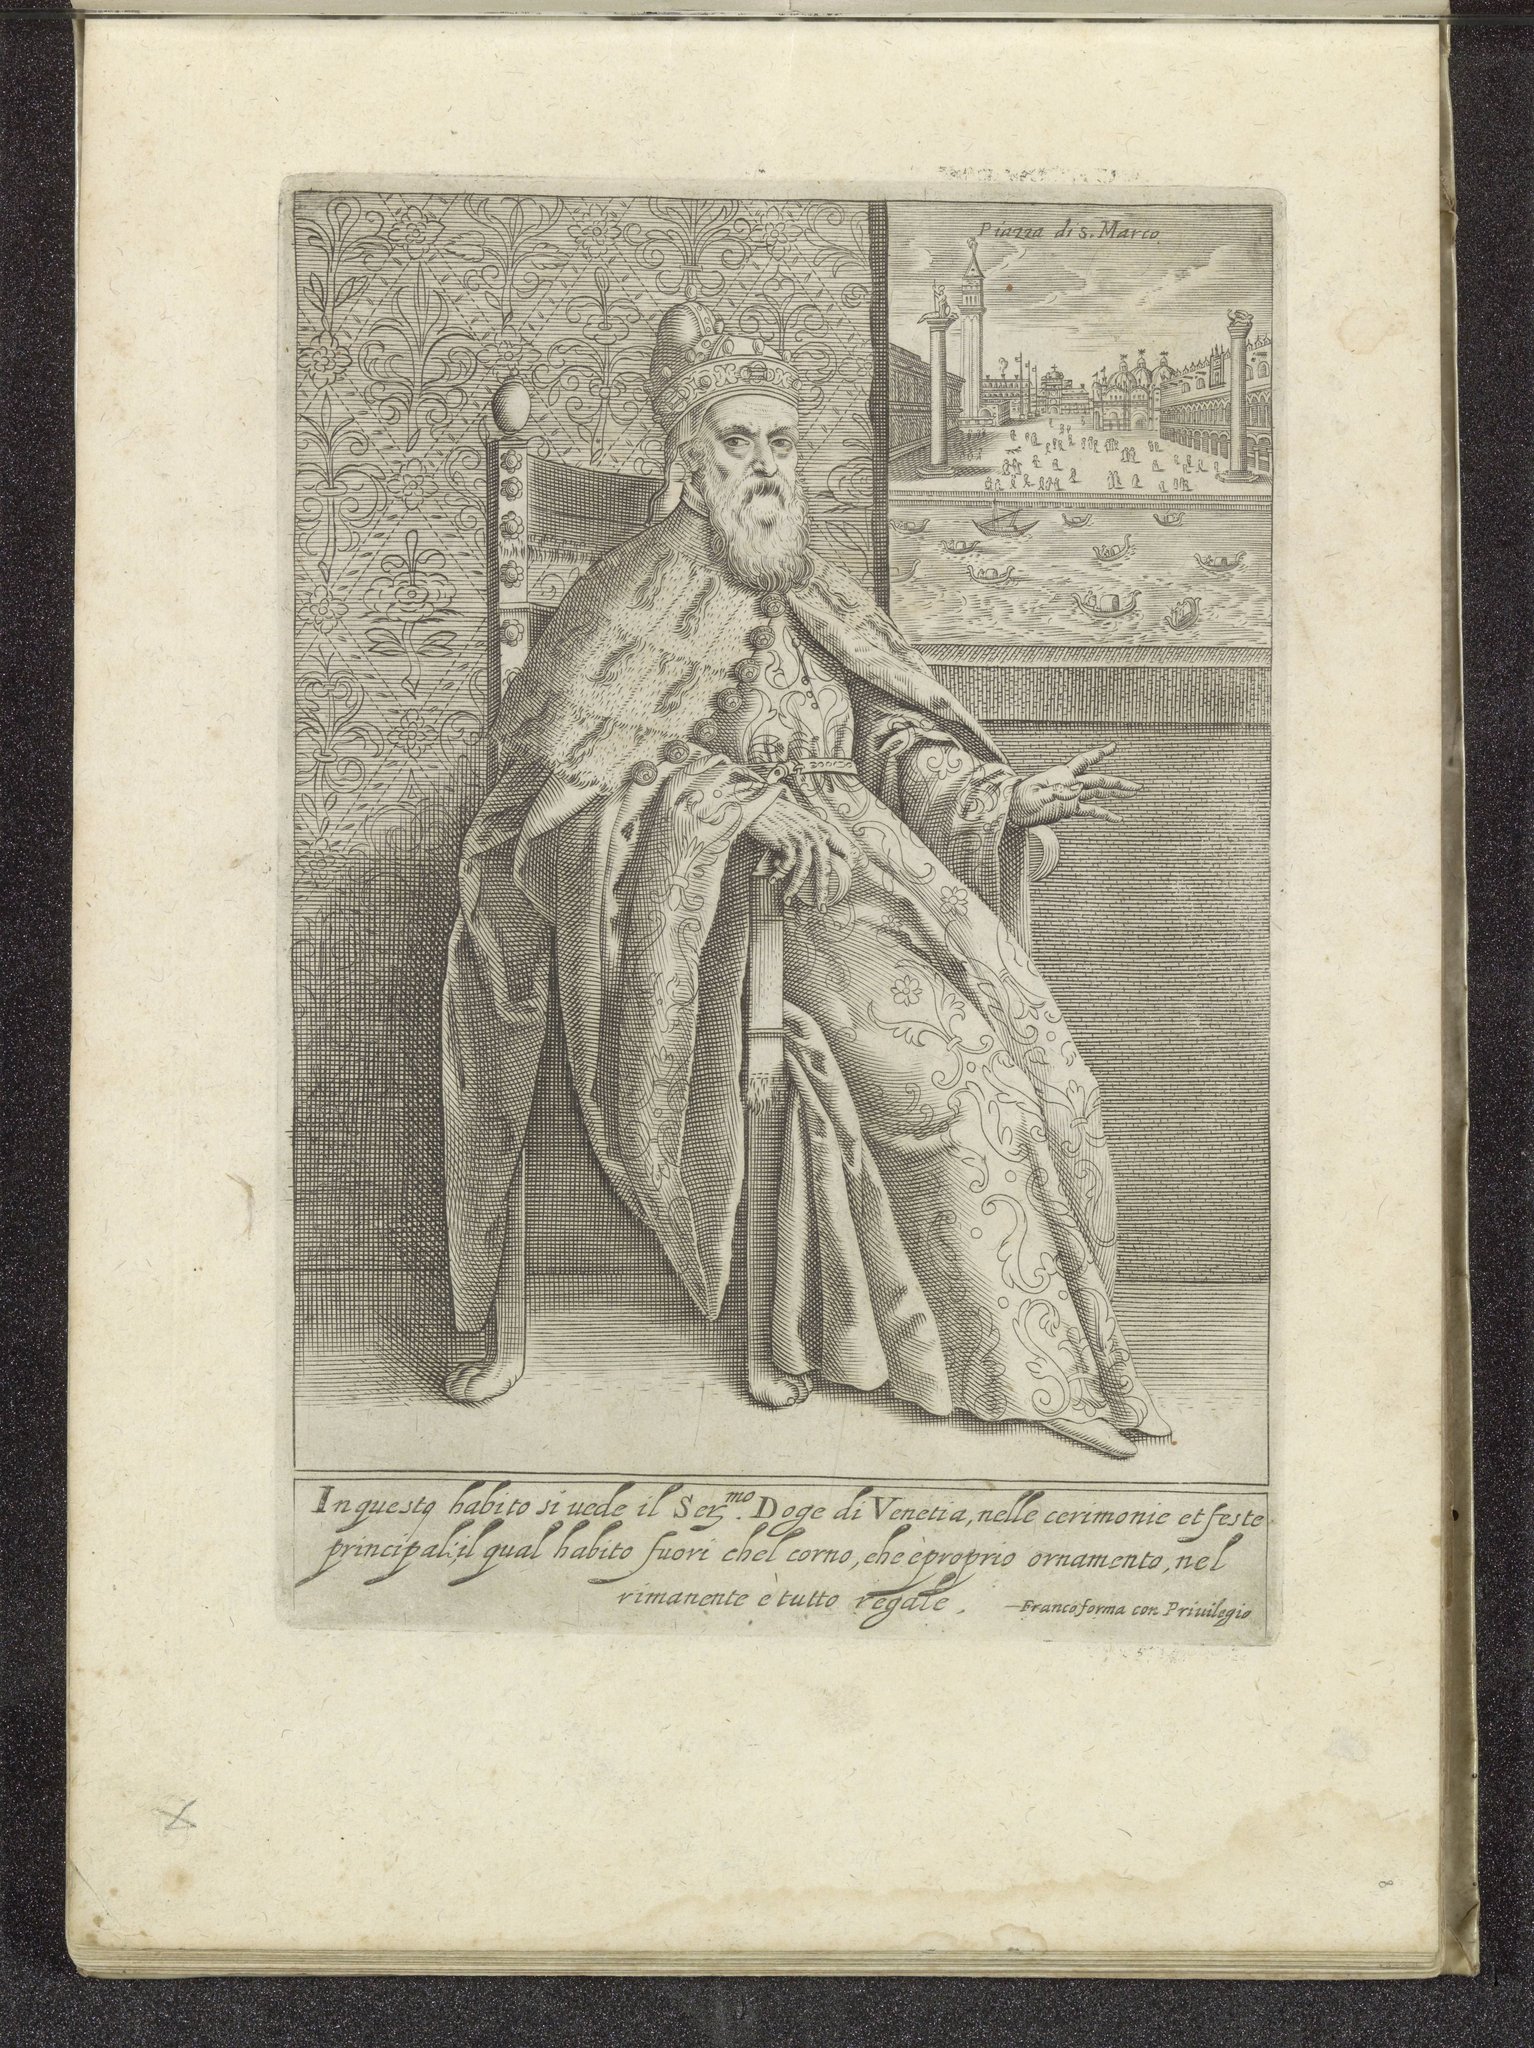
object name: album leaf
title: Scènes uit het Venetiaanse leven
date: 1610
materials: paper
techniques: engraving, intaglio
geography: venice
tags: other sovereign: doge, venice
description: De doge zittend in een interieur. Rechts een doorkijk naar het San Marcoplein te Venetië. Drieregelige Italiaanse tekst in ondermarge. De prent maakt deel uit van een album.